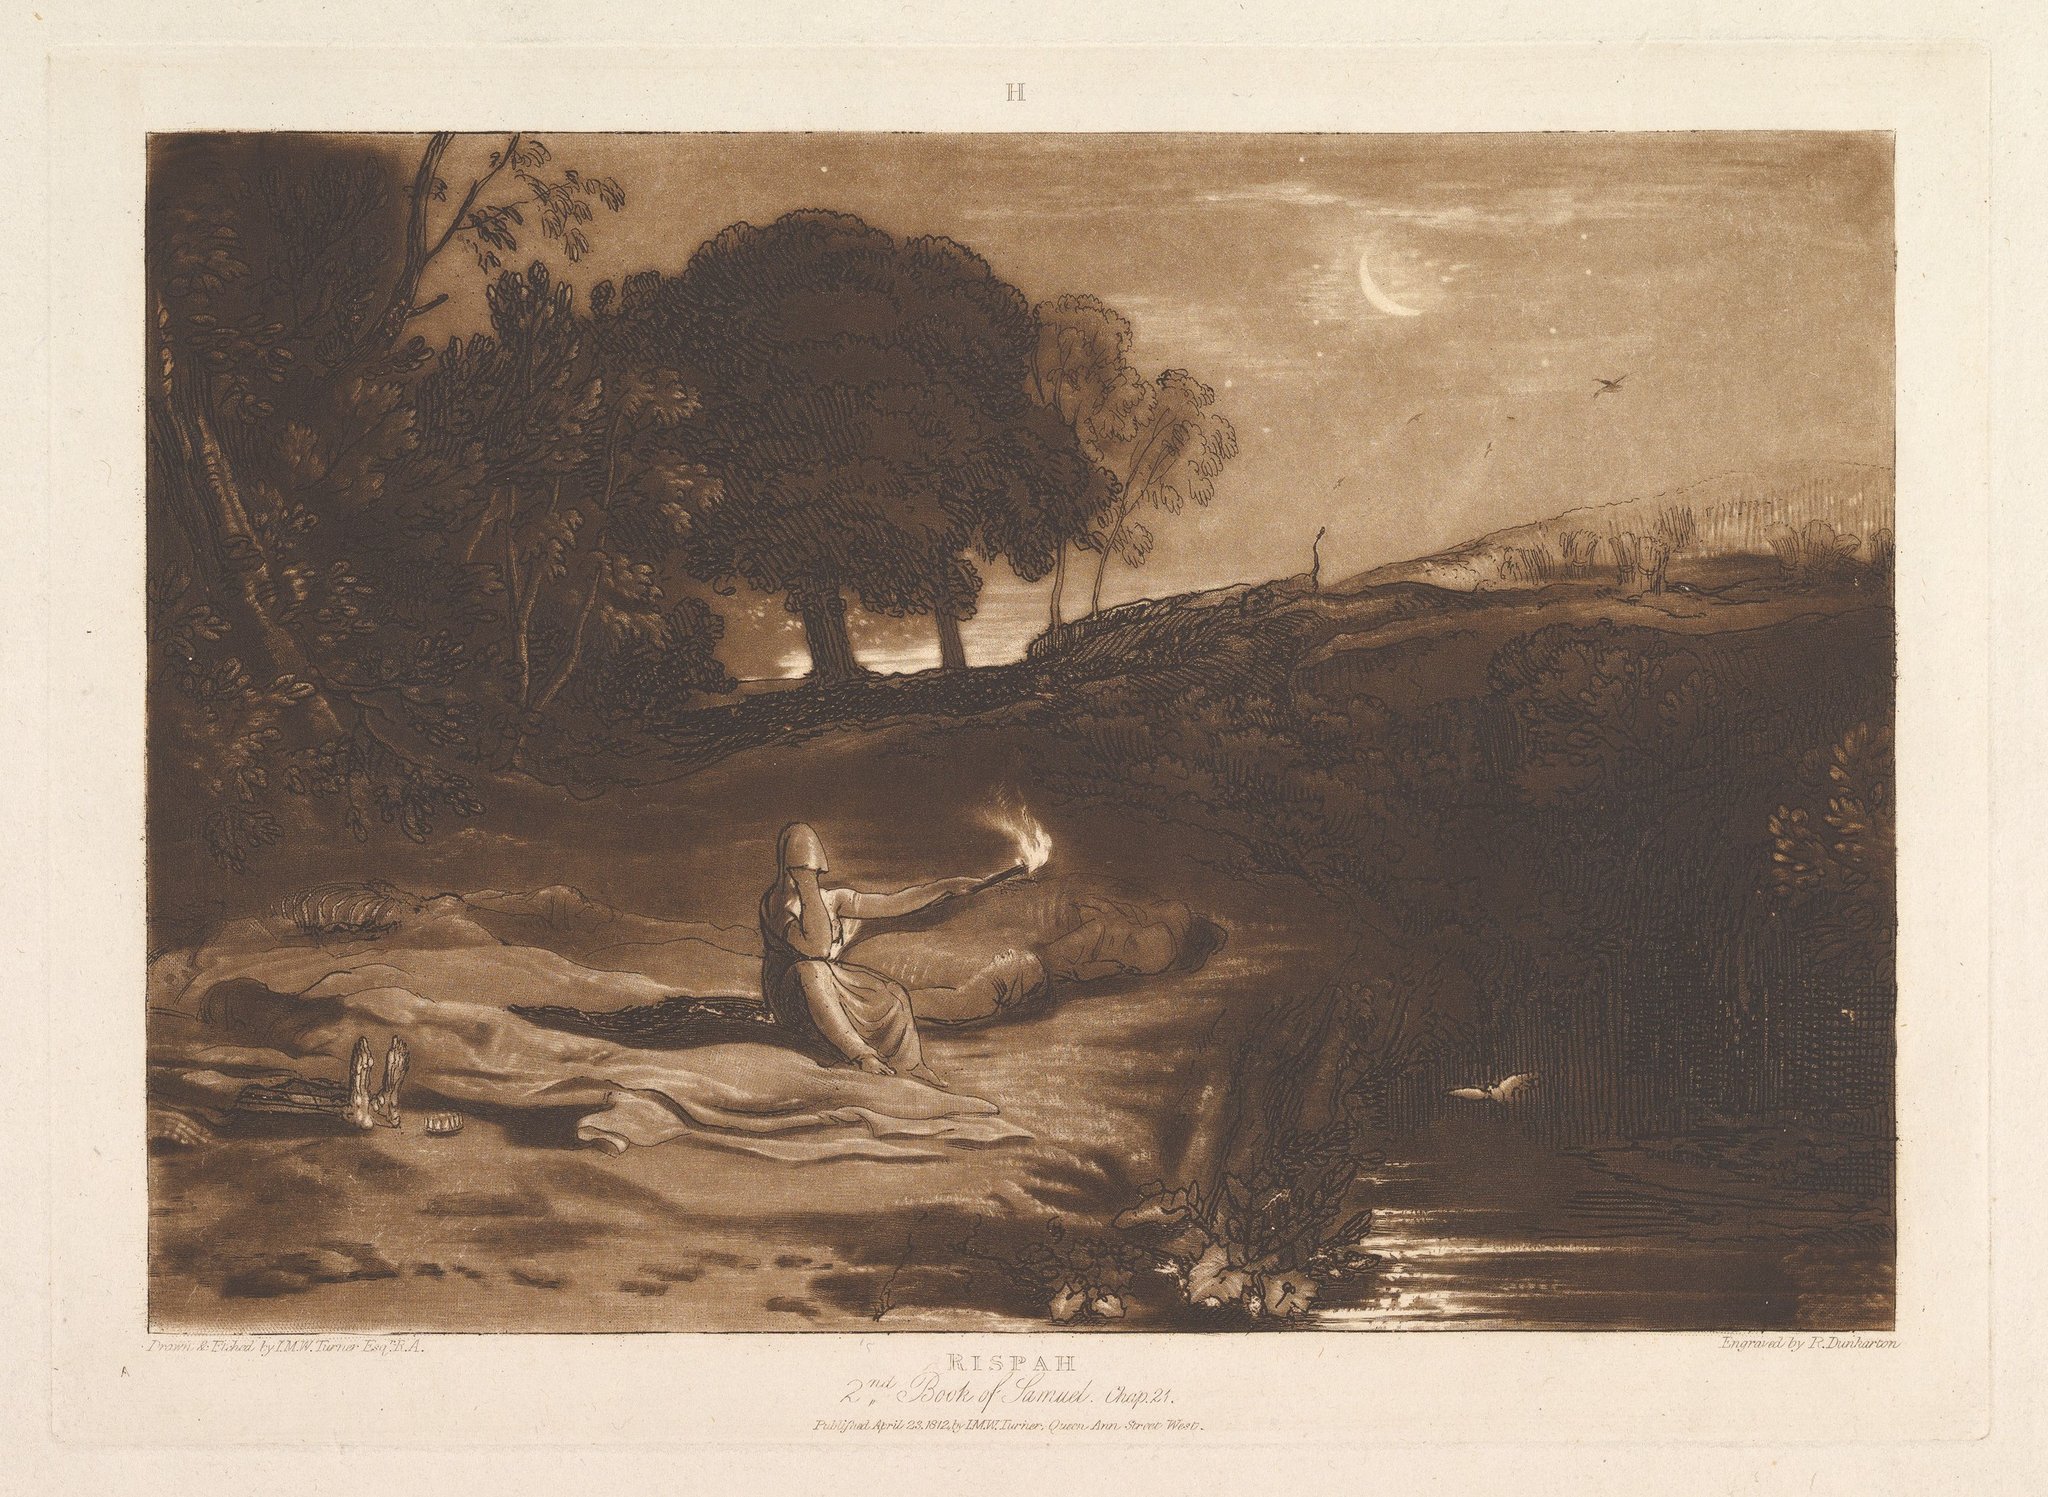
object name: print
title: Rispah, 2nd Book of Samuel, Chapter 21 (Liber Studiorum, part IX, plate 46)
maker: joseph mallord william turner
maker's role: artist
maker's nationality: british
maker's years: 1775-1851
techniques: etching, mezzotint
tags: women,moon,trees,night